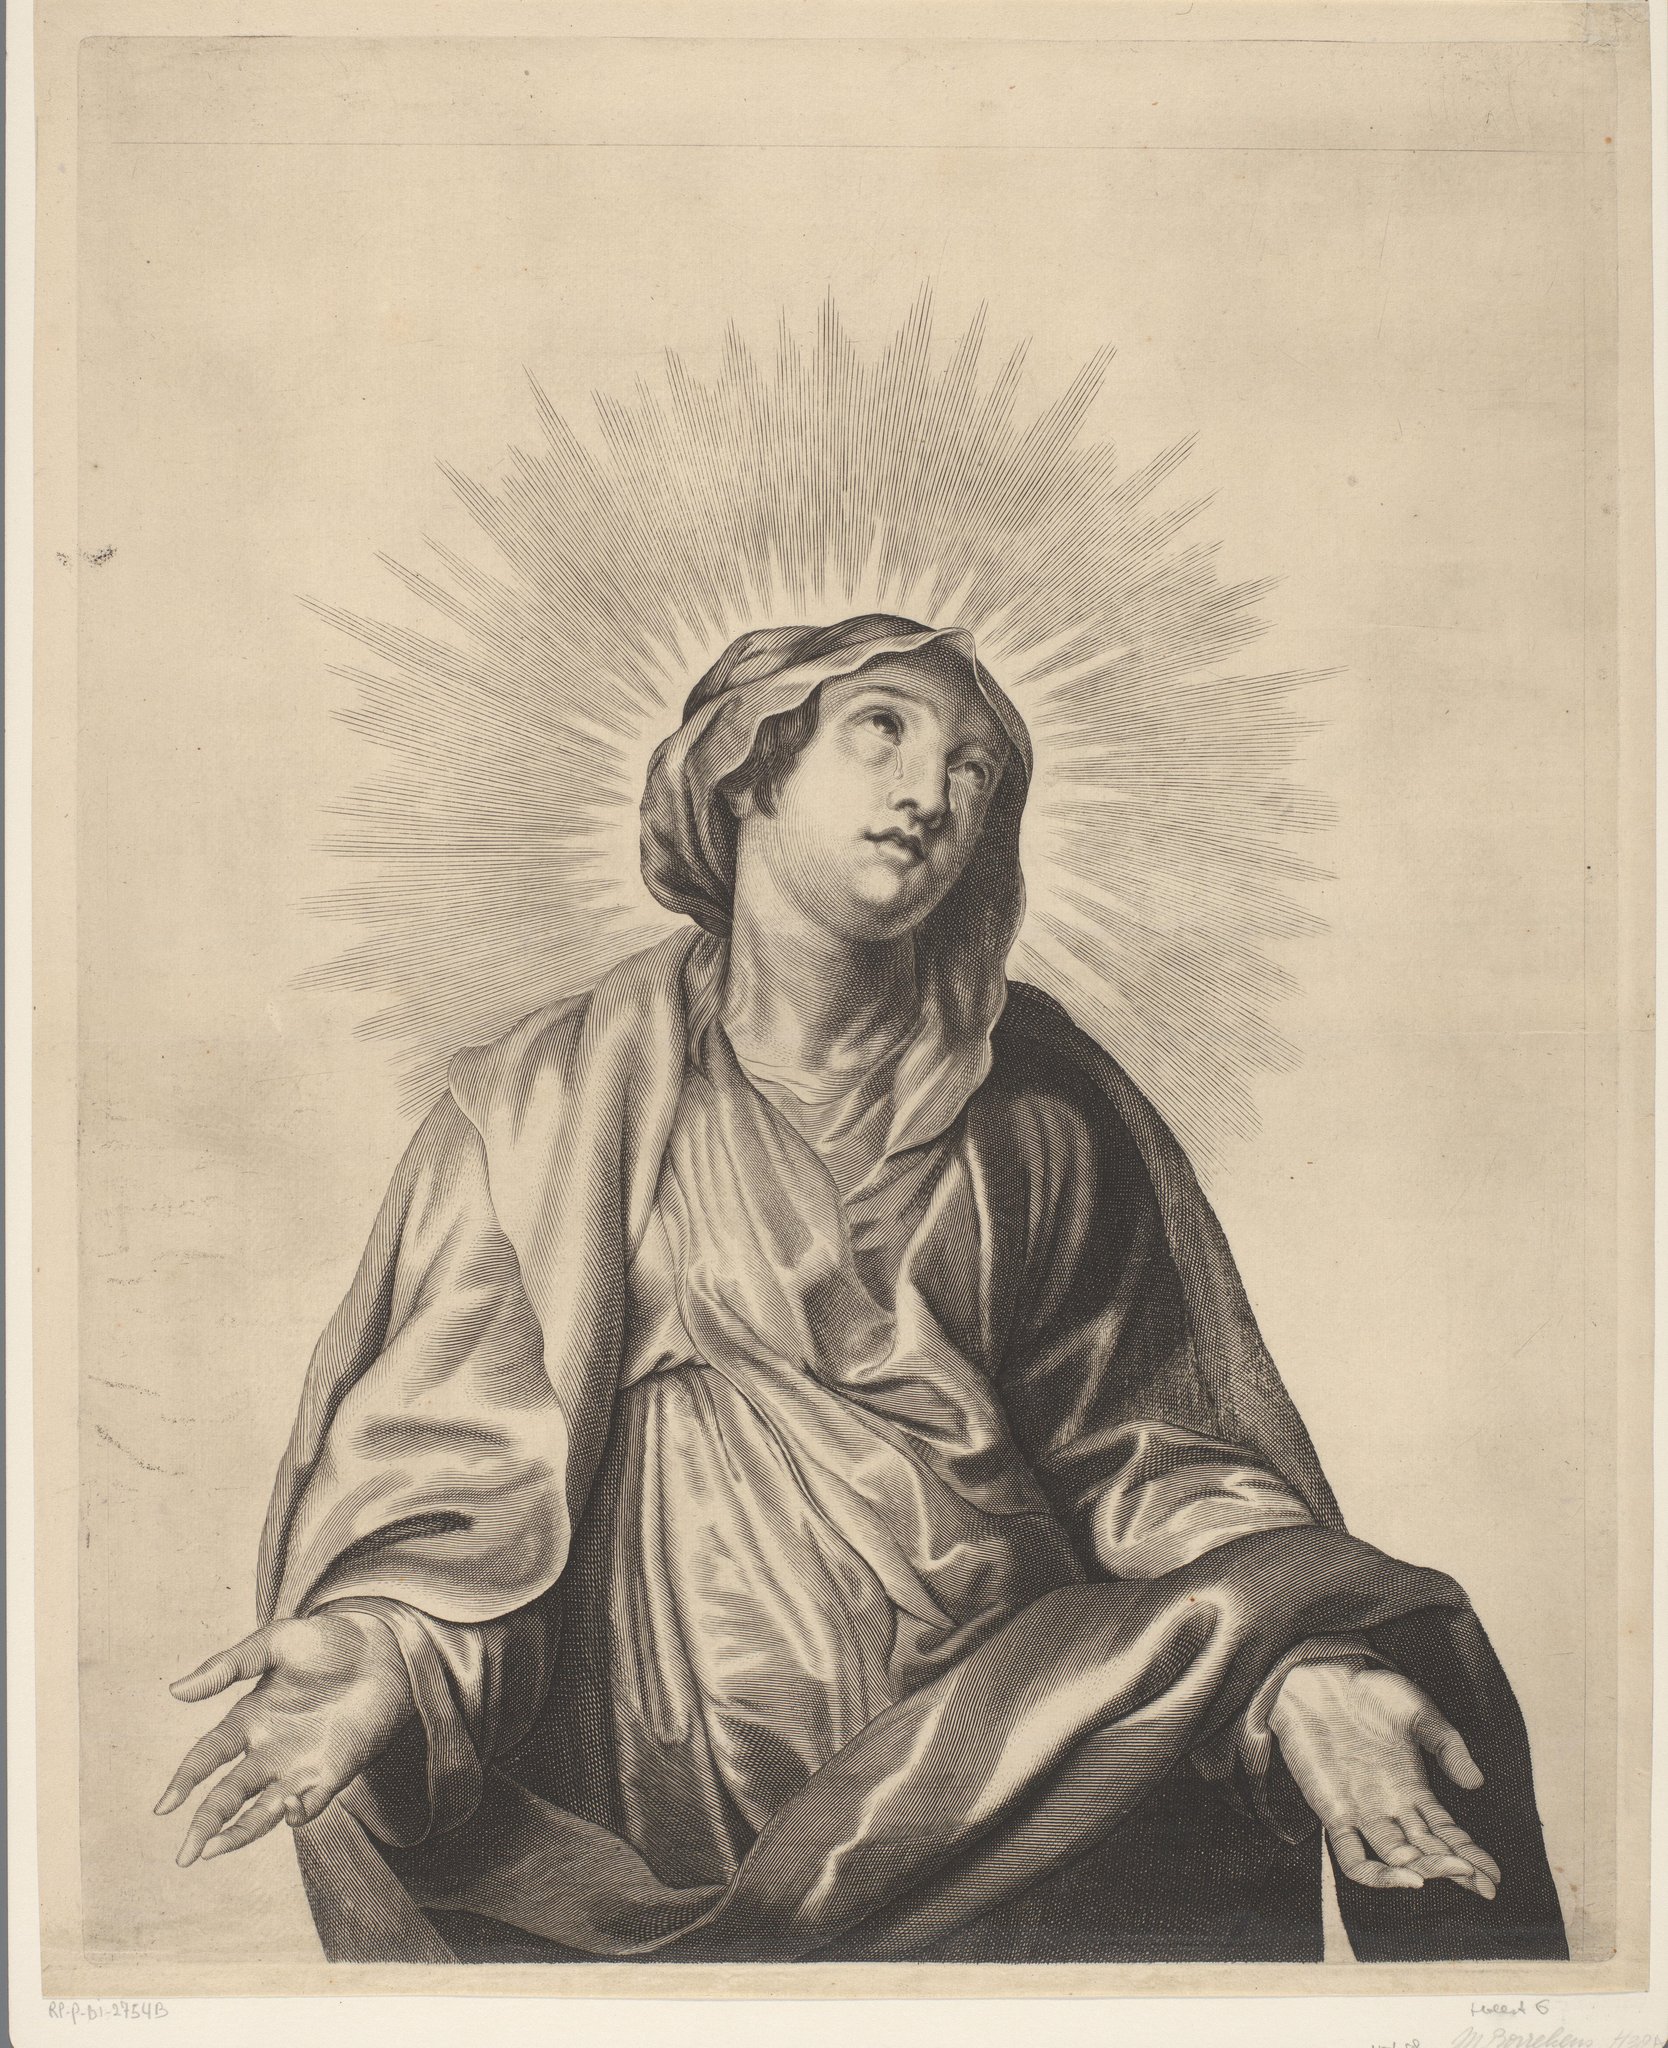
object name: print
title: Maria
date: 1650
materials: paper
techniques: engraving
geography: antwerp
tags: series of scenes from the life of mary, prospect of city, town panorama, silhouette of city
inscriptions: collector's mark: Lugt 240 of 1838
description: Bovenplaat. Op de voorgrond van de prent staat Maria. Haar ogen zijn naar de hemel gericht. Ze huilt. Op de achtergrond een stadsgezicht.